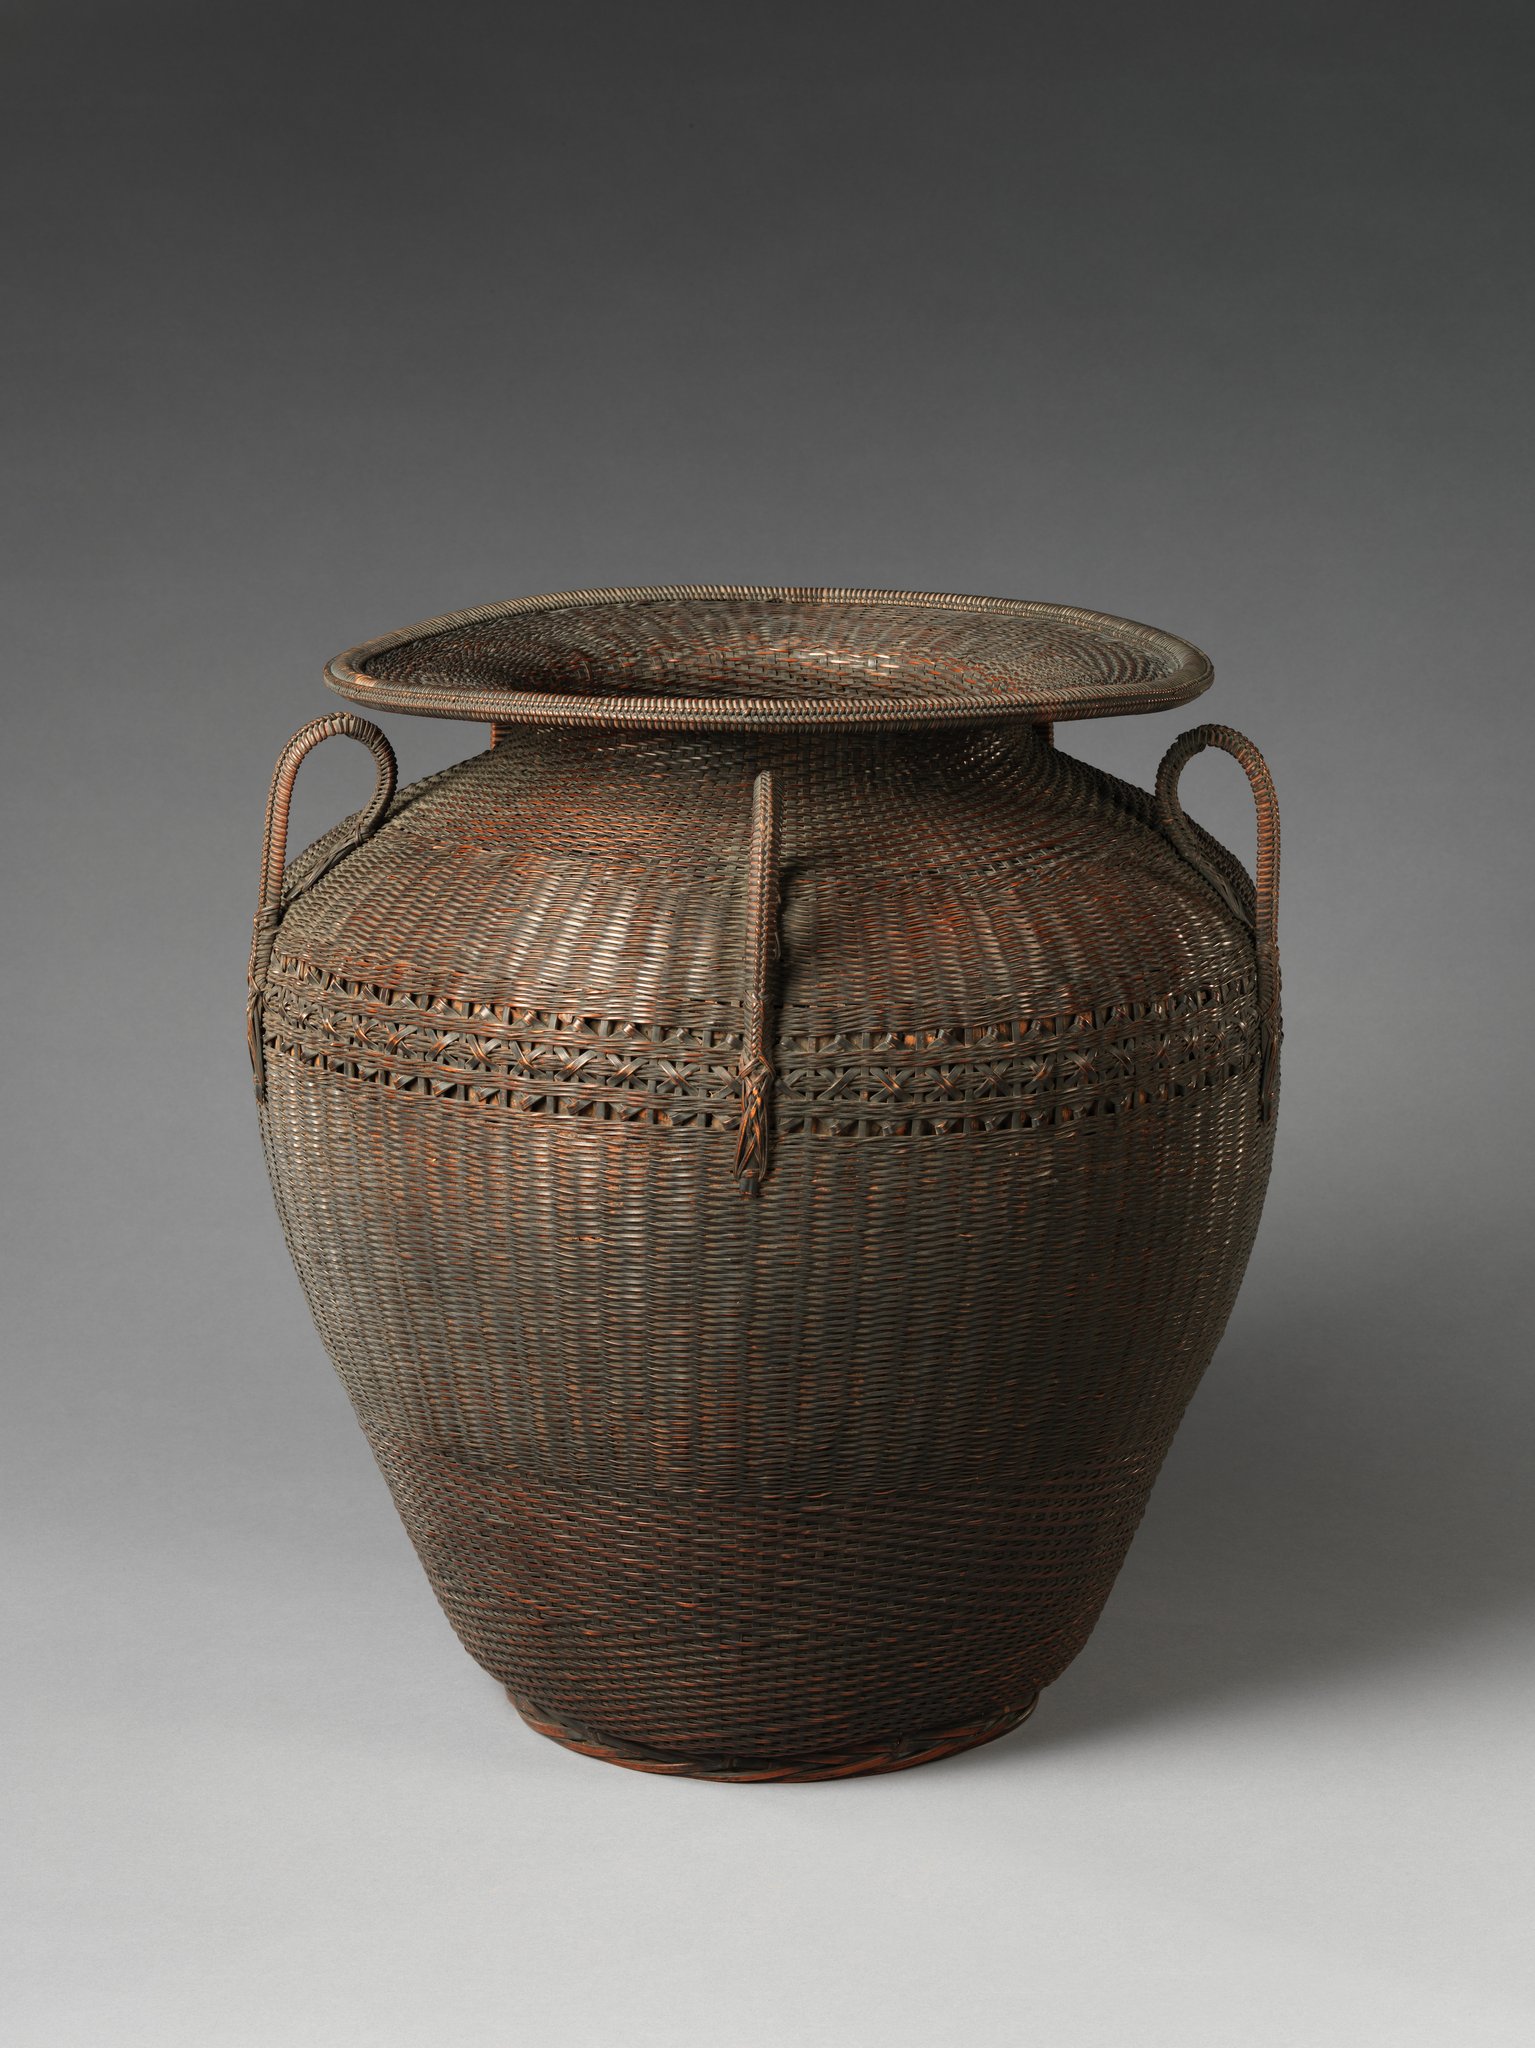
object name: basket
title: Karamono-Style Flower Basket (Hanakago)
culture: japanese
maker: hayakawa shōkosai i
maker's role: artist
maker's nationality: japanese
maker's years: 1815-1897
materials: bamboo, rattan